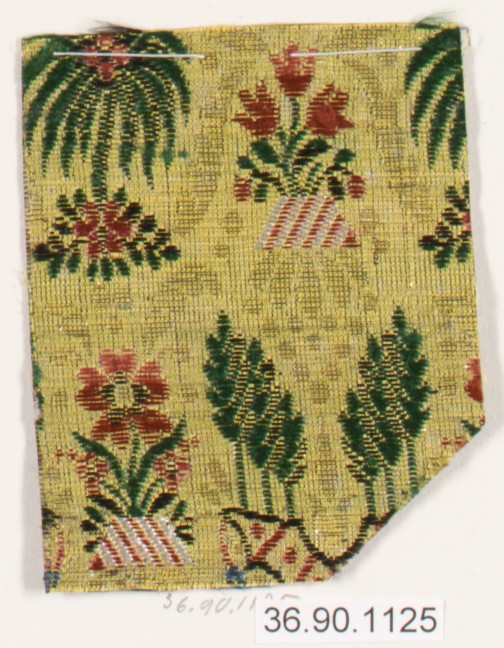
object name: sample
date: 1701-1900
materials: metal thread, silk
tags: flowers